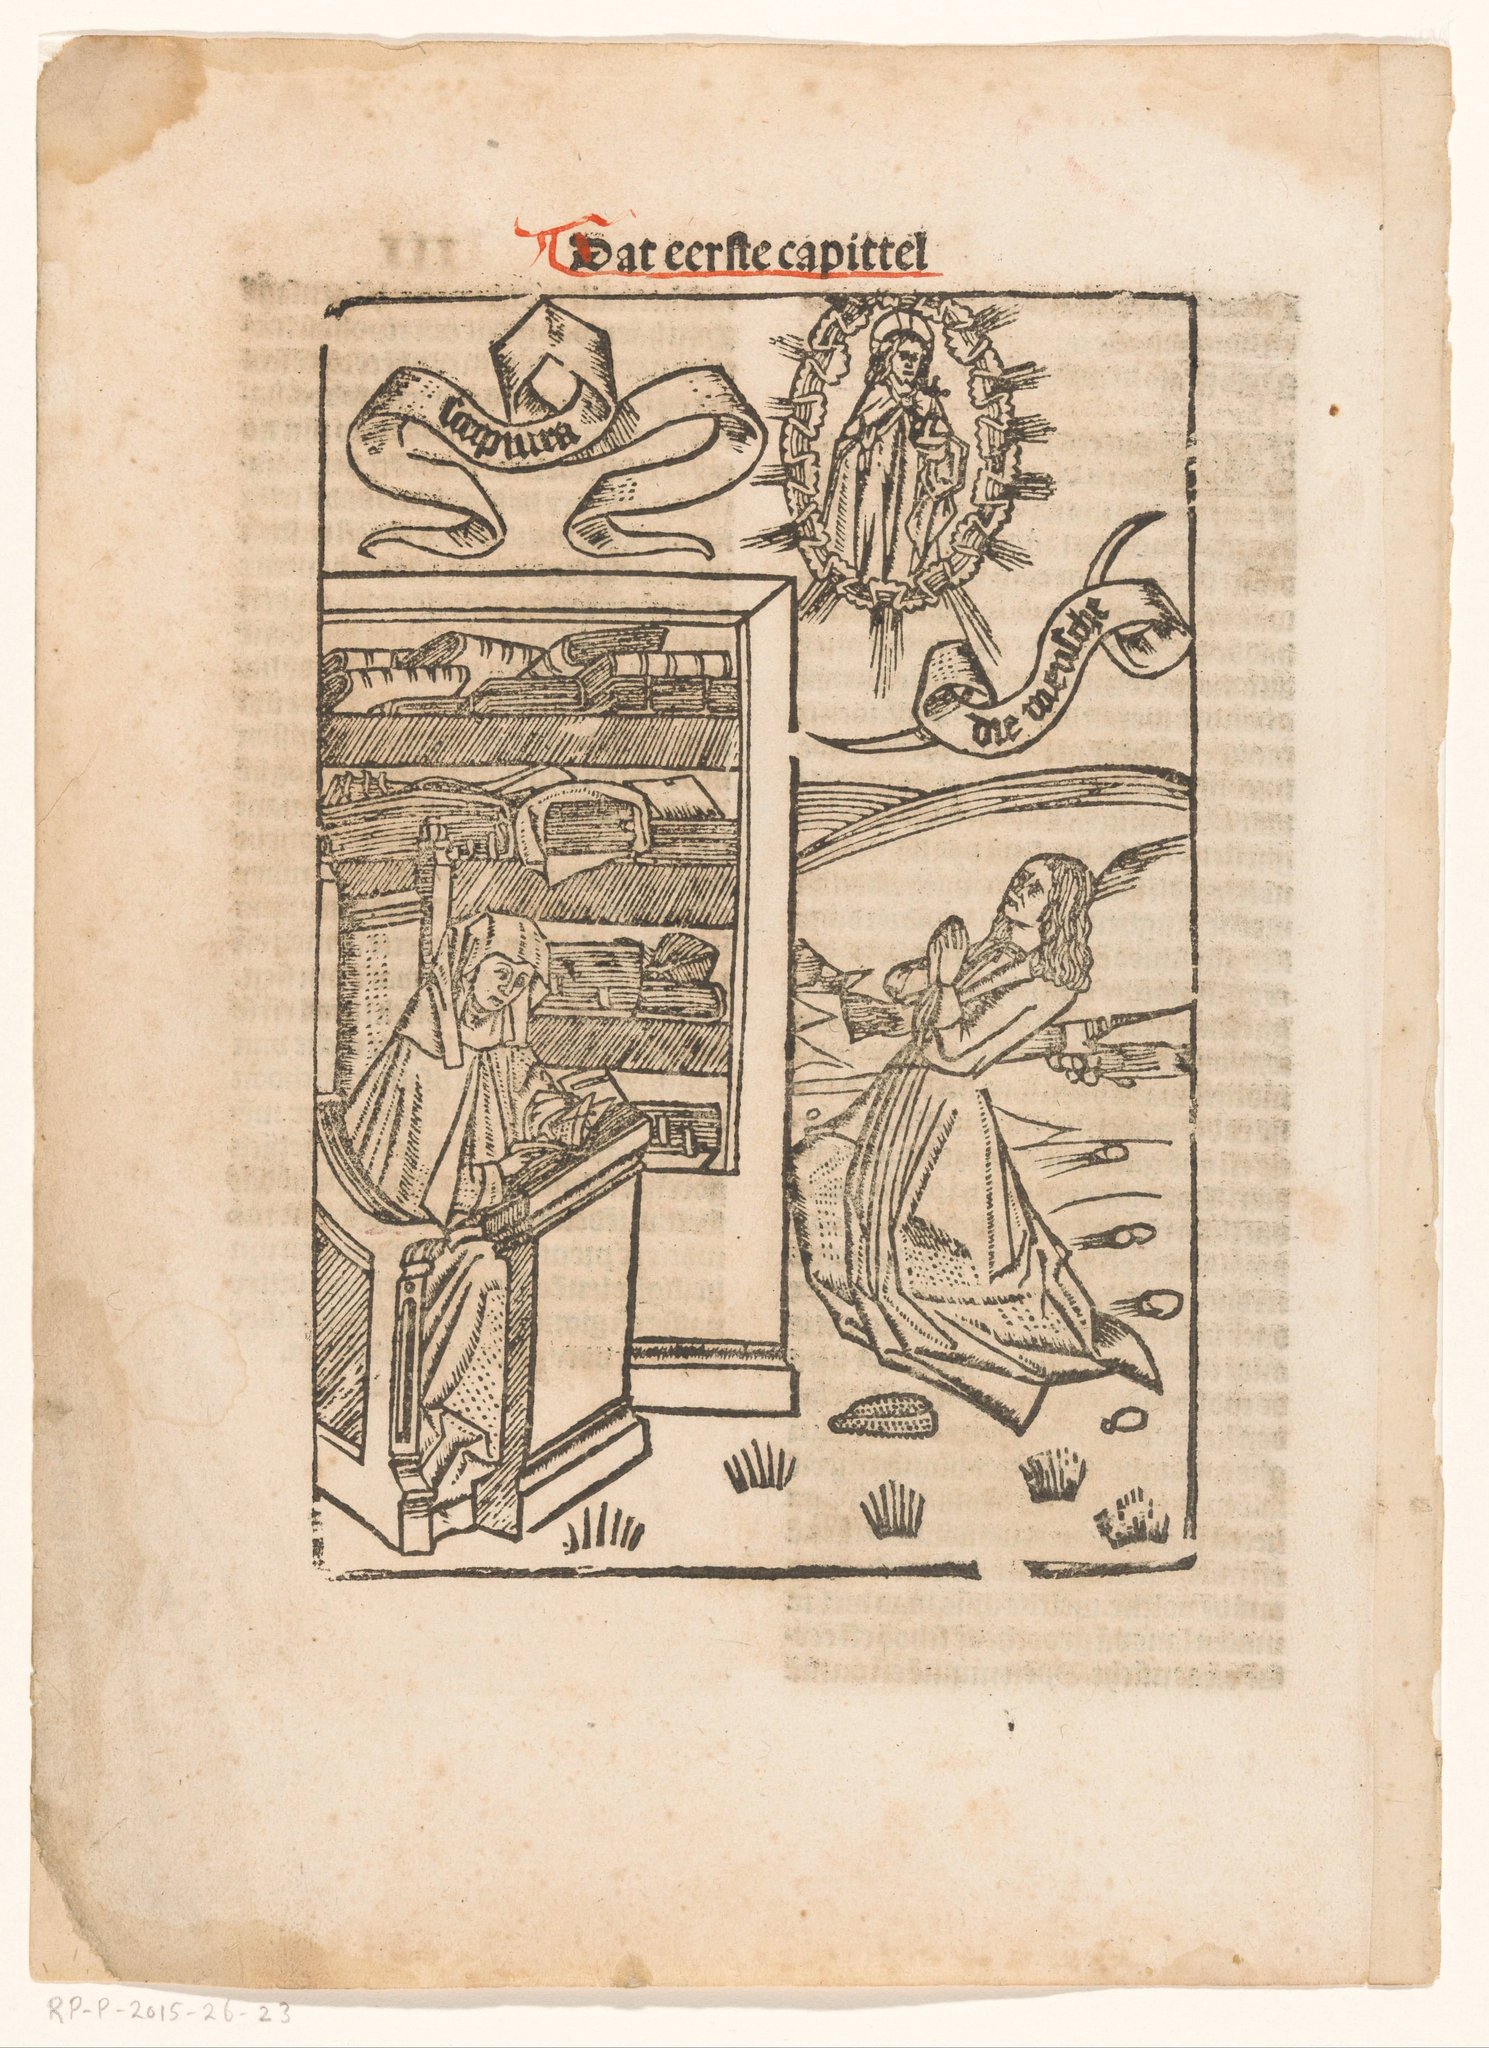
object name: book illustration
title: Scriptura en de mens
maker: Anonymous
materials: paper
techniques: letterpress printing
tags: 'salvator mundi', making a blessing gesture; an orb in his hand or at his feet, personification of holy writ, 'sacra scriptura', reading the bible or other religious books, the bible as a book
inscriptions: collector's mark: Lugt 2228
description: Deze houtsnede werd voor het eerst gebruikt in: Ludolphus de Saxonia. Tboeck vanden leven Jhesu Christi [eerste Nederlandse vertaling in druk van Vita Christi], Antwerpen: Gerard Leeu, 3 Nov. 1487, a3 verso. Mogelijk is dit blad afkomstig uit een latere editie, verschenen bij Claes Leeu in Antwerpen of Peter van Os in Breda, tussen 1488-1499.